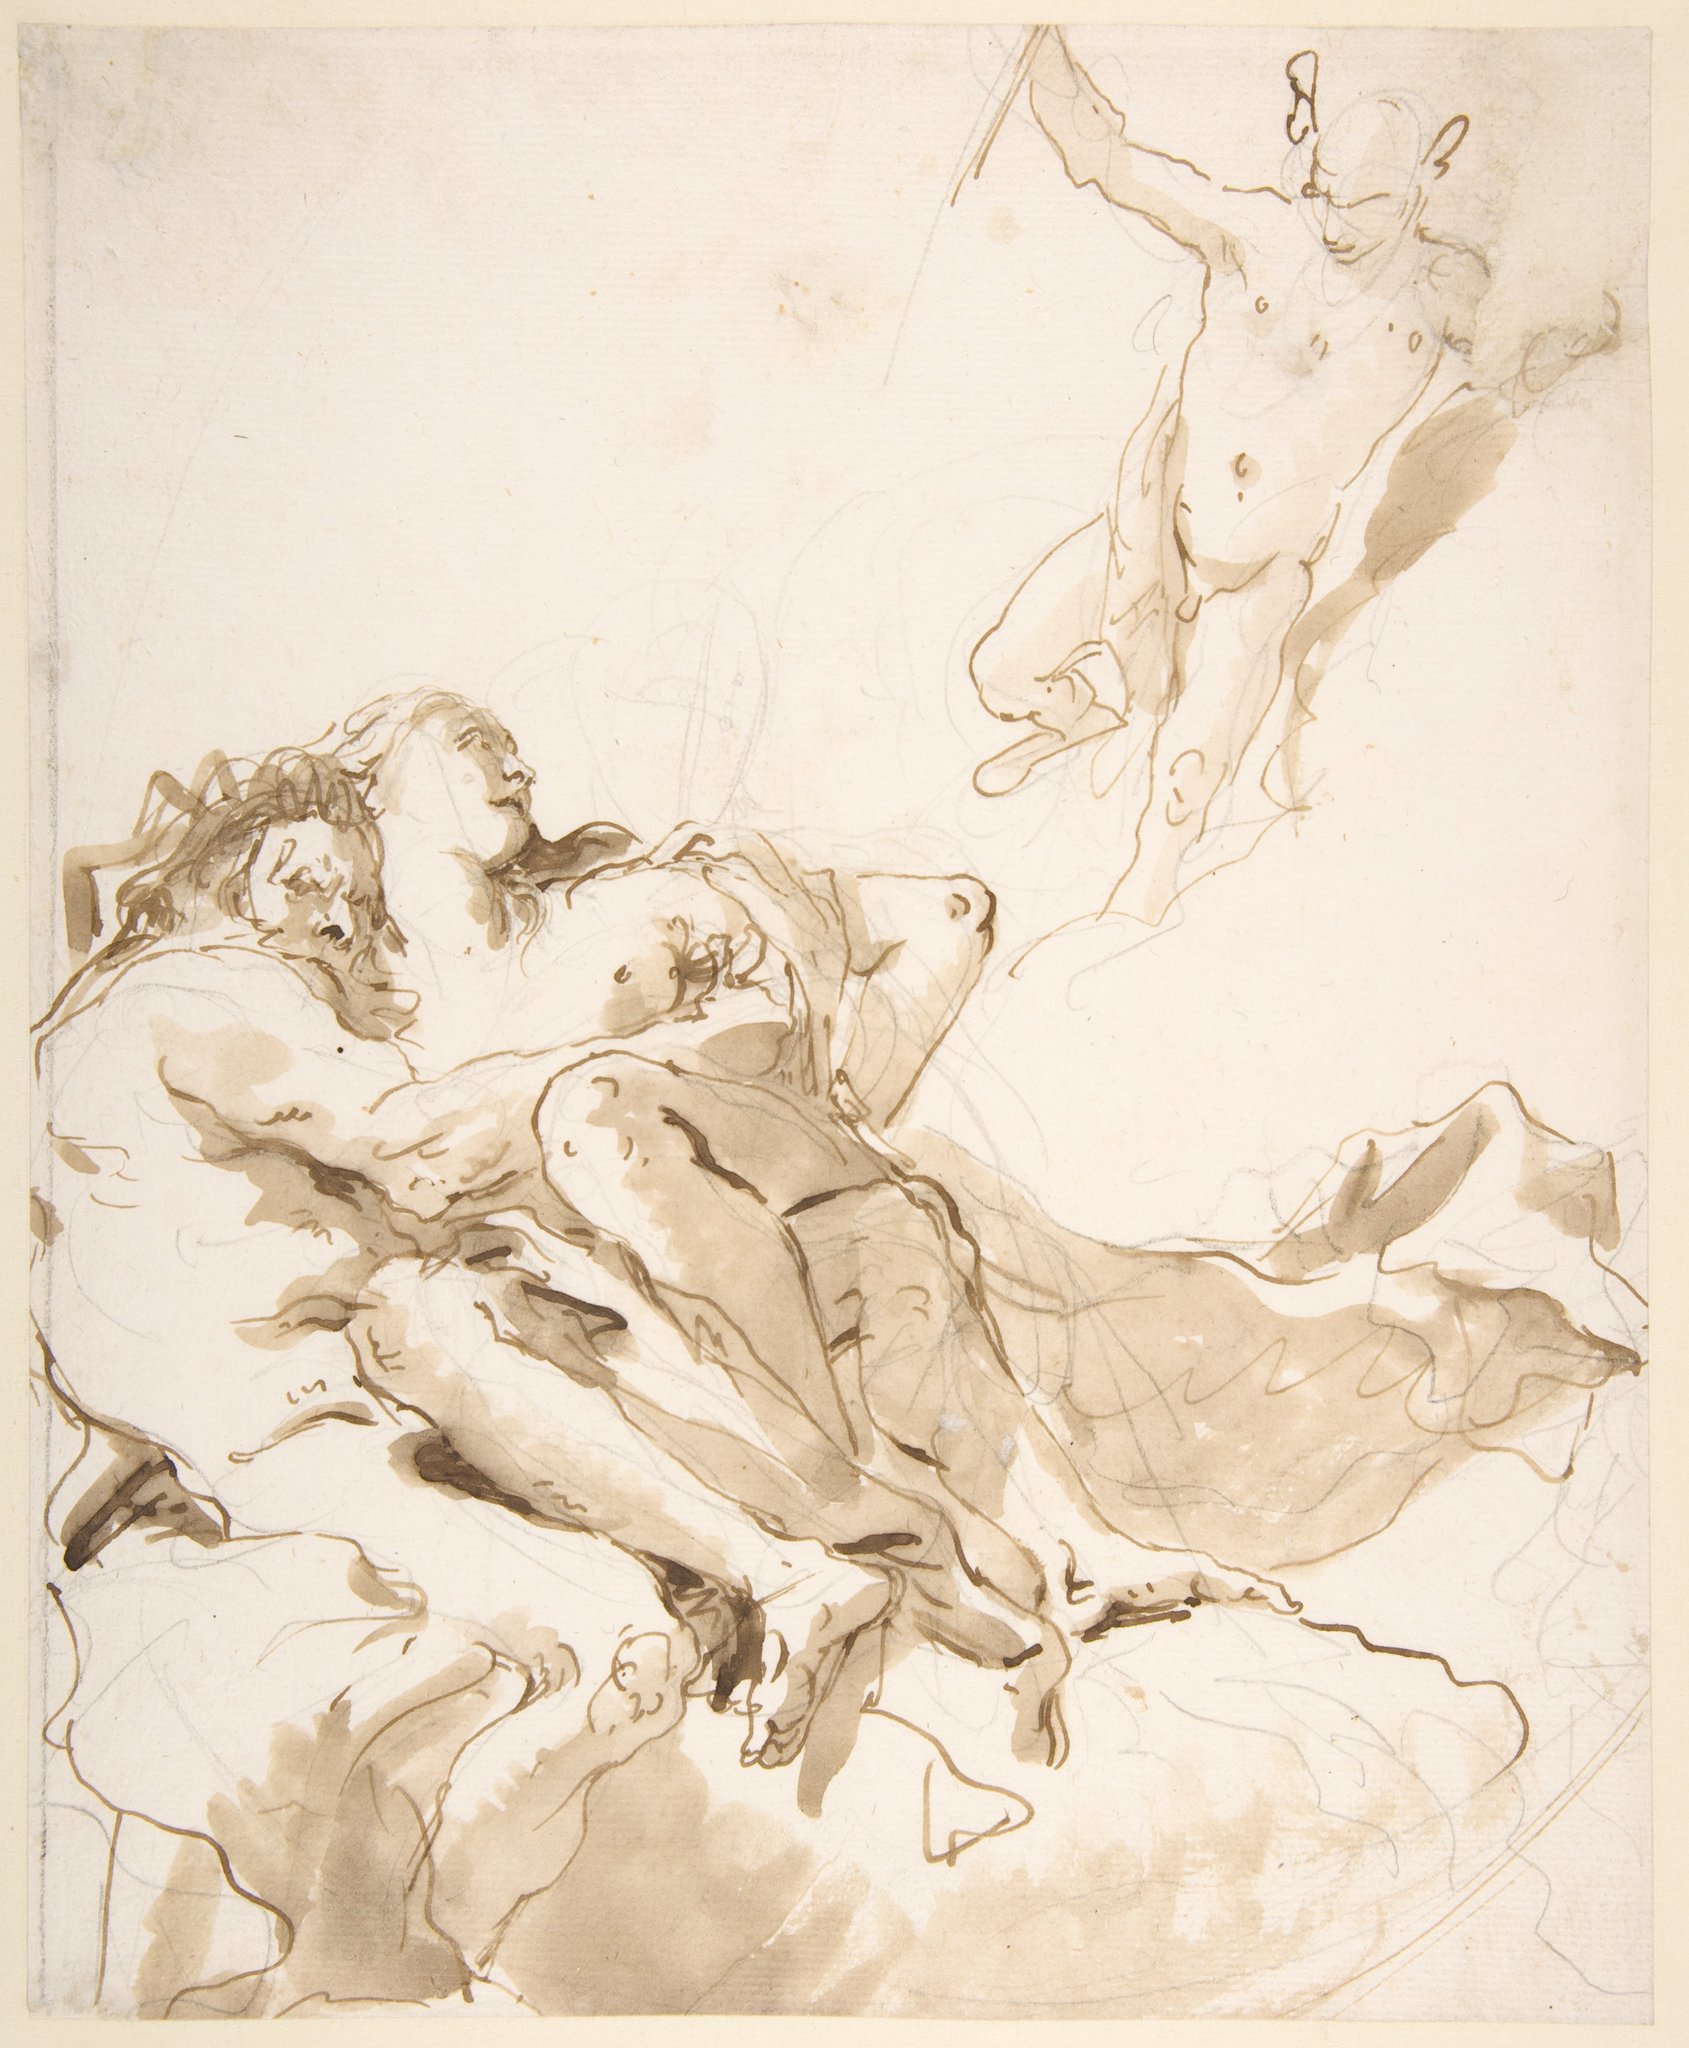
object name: drawing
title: Mercury Appearing to a Marine Deity and a Nymph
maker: giovanni battista tiepolo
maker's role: artist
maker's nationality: italian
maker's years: 1696-1770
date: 1696-1770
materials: chalk, ink, drawing material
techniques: brush, pen, wash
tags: nymphs,mercury